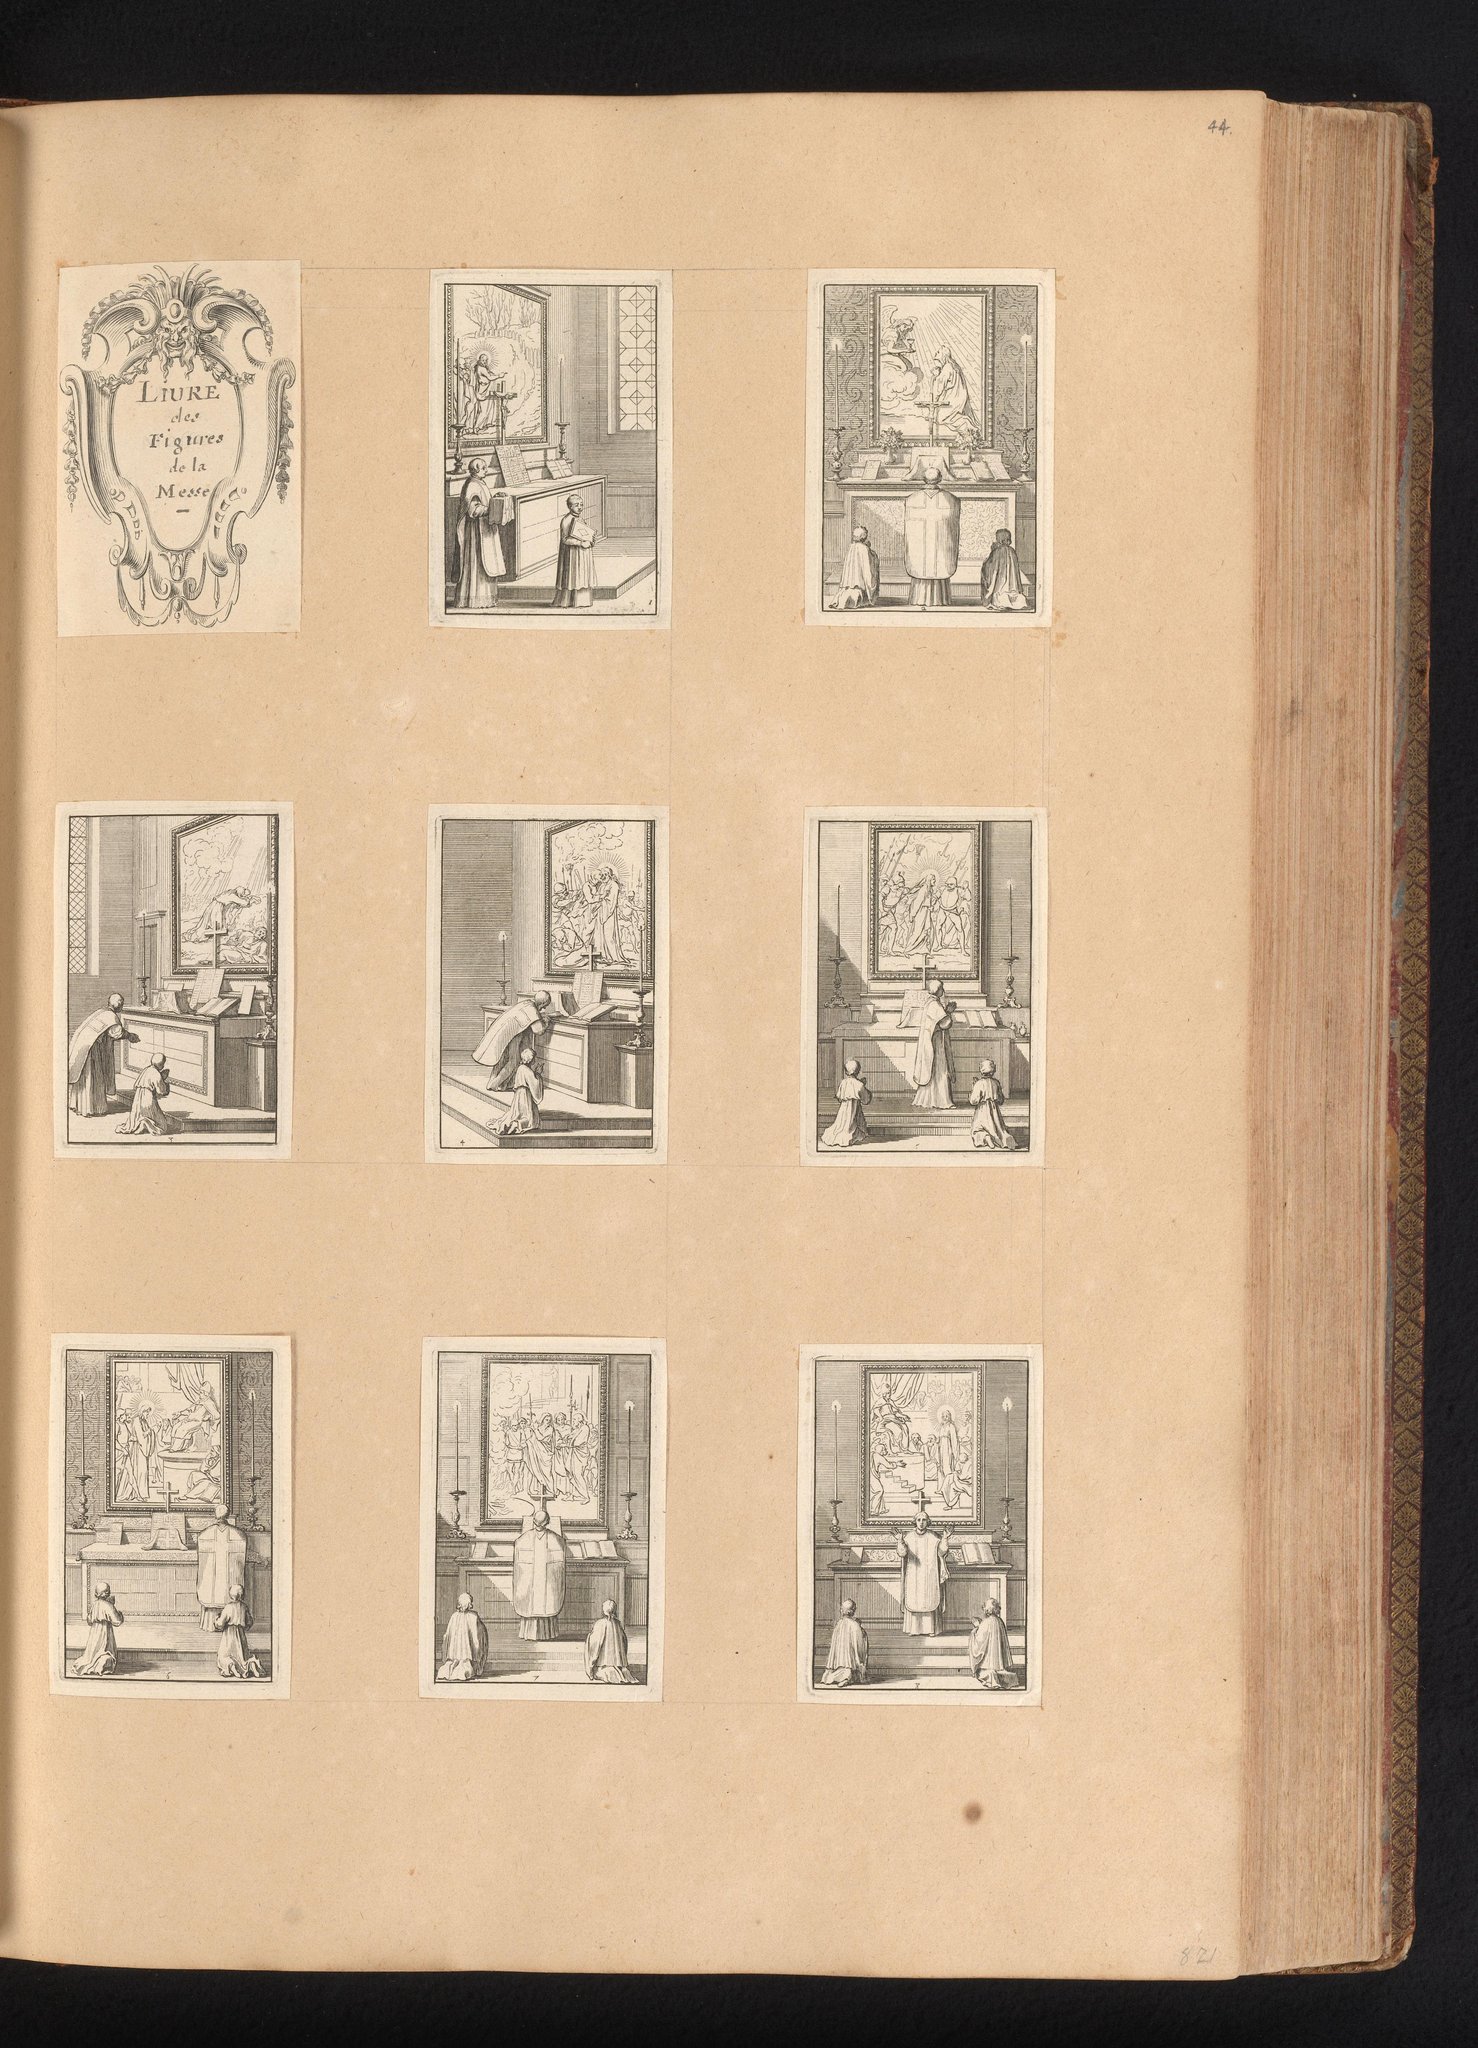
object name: titelprent, frontispice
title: Gebruiken van priesters tijdens de mis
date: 1680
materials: ink, paper, pencil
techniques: etching, pen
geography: metz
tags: priest (roman catholic), holy mass (divine service, especially of roman catholic church), altar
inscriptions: inscription: ‘Livre des Figures de la Messe’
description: Prenten maken deel uit van een serie met 35 prenten met voorstellingen van gebruiken van priesters tijdens de mis. De serie wordt ook wel 'La Troisième Messe' genoemd.